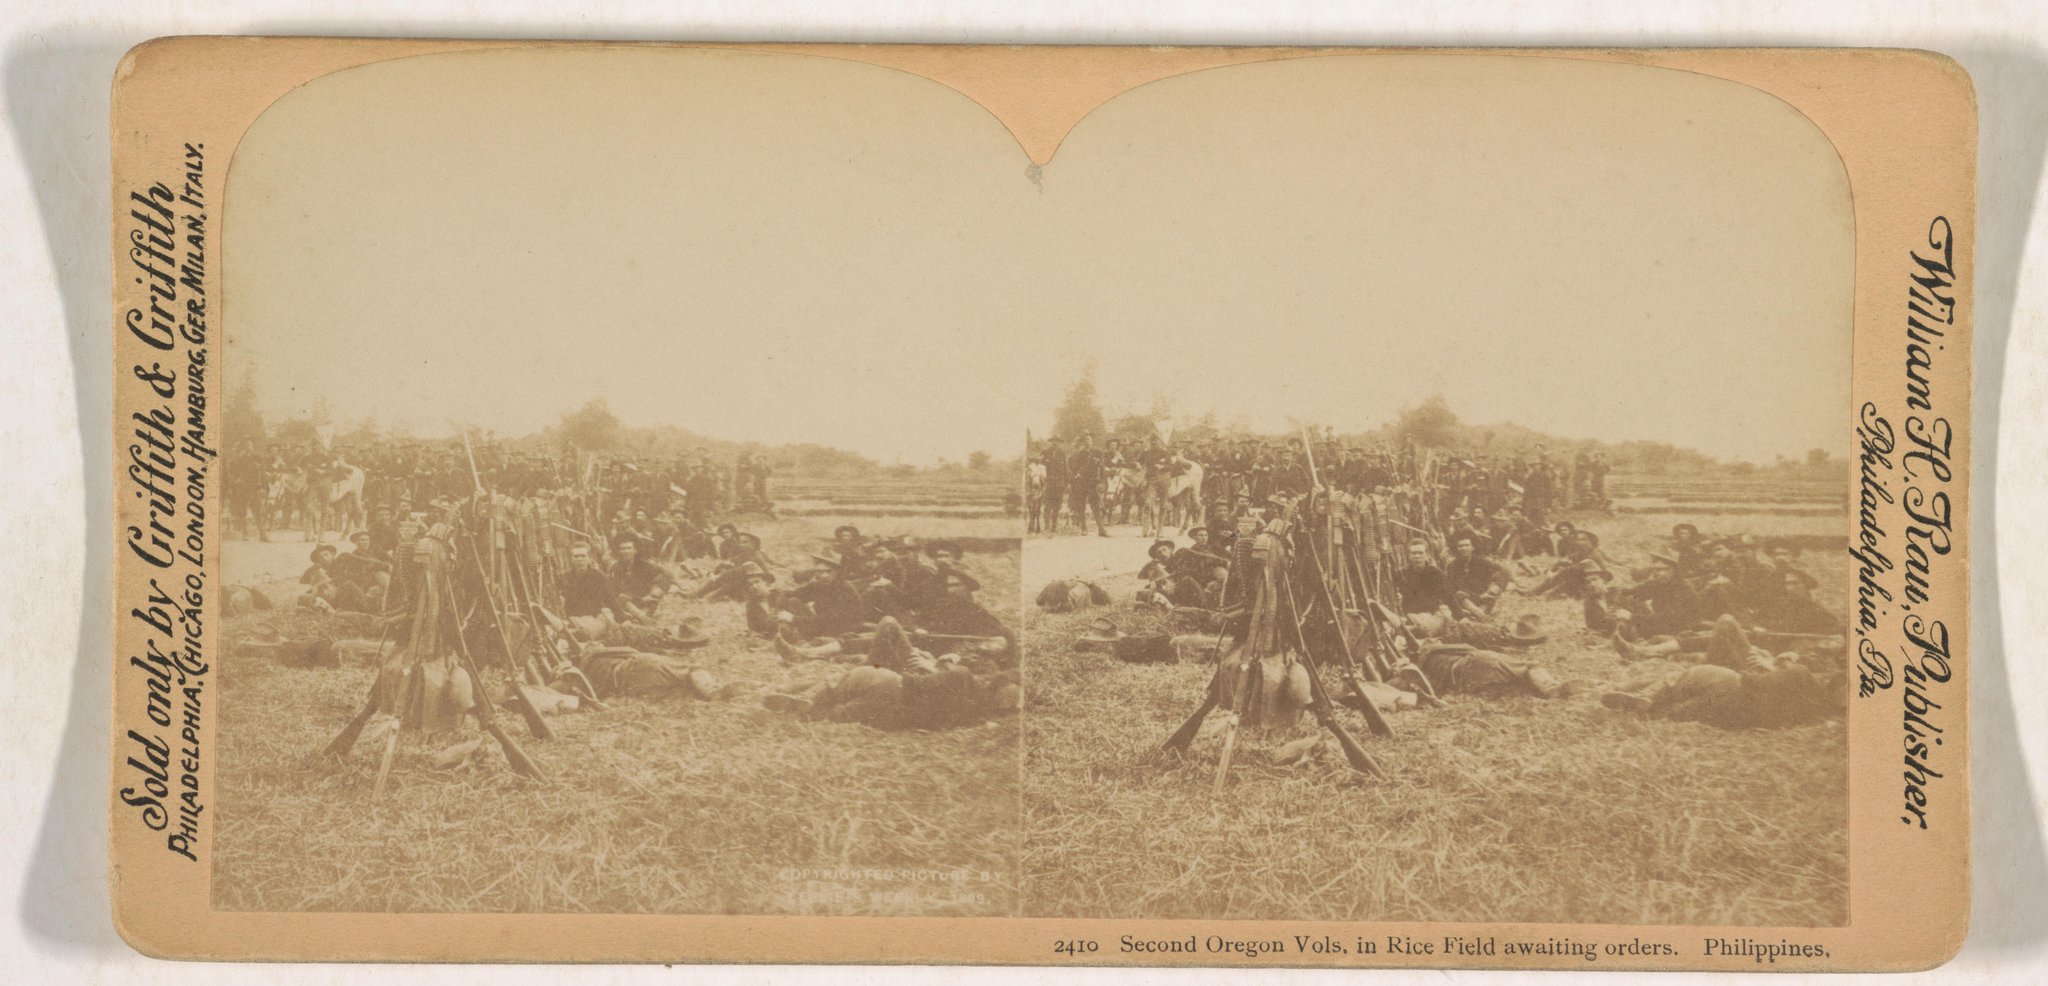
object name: stereograph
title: Second Oregon Vols, in Rice Field awaiting orders. Philippines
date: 1899-1913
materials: cardboard, paper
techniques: albumen print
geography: philippines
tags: the soldier; the soldier's life, philippines, philippine–american war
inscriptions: number: ‘25’, number: ‘2410’, number: ‘12’